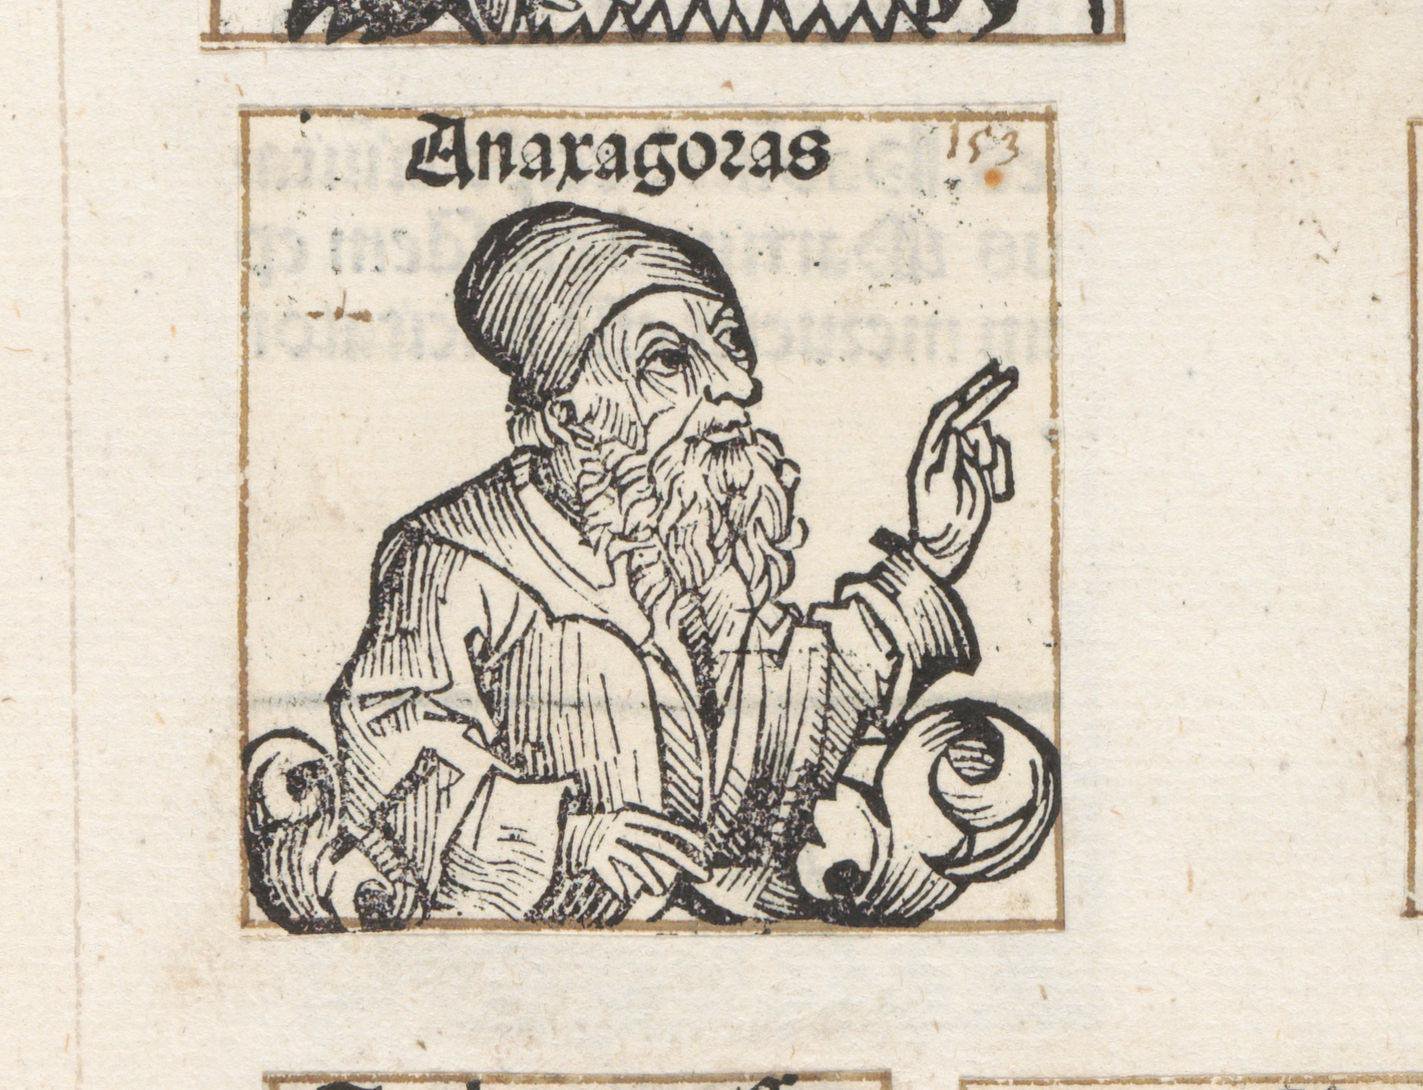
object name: album leaf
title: Anaxagoras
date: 1493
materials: paper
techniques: letterpress printing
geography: nuremberg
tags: male persons from classical history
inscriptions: inscription: ‘153’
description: De houtsnede wordt gebruikt als boekillustratie in de Liber Chronicarum (of Neurenbergkroniek) van Hartmann Schedel, verschenen in het Latijn en Duits in 1493. Zie de Latijnse uitgave, folio 71r.